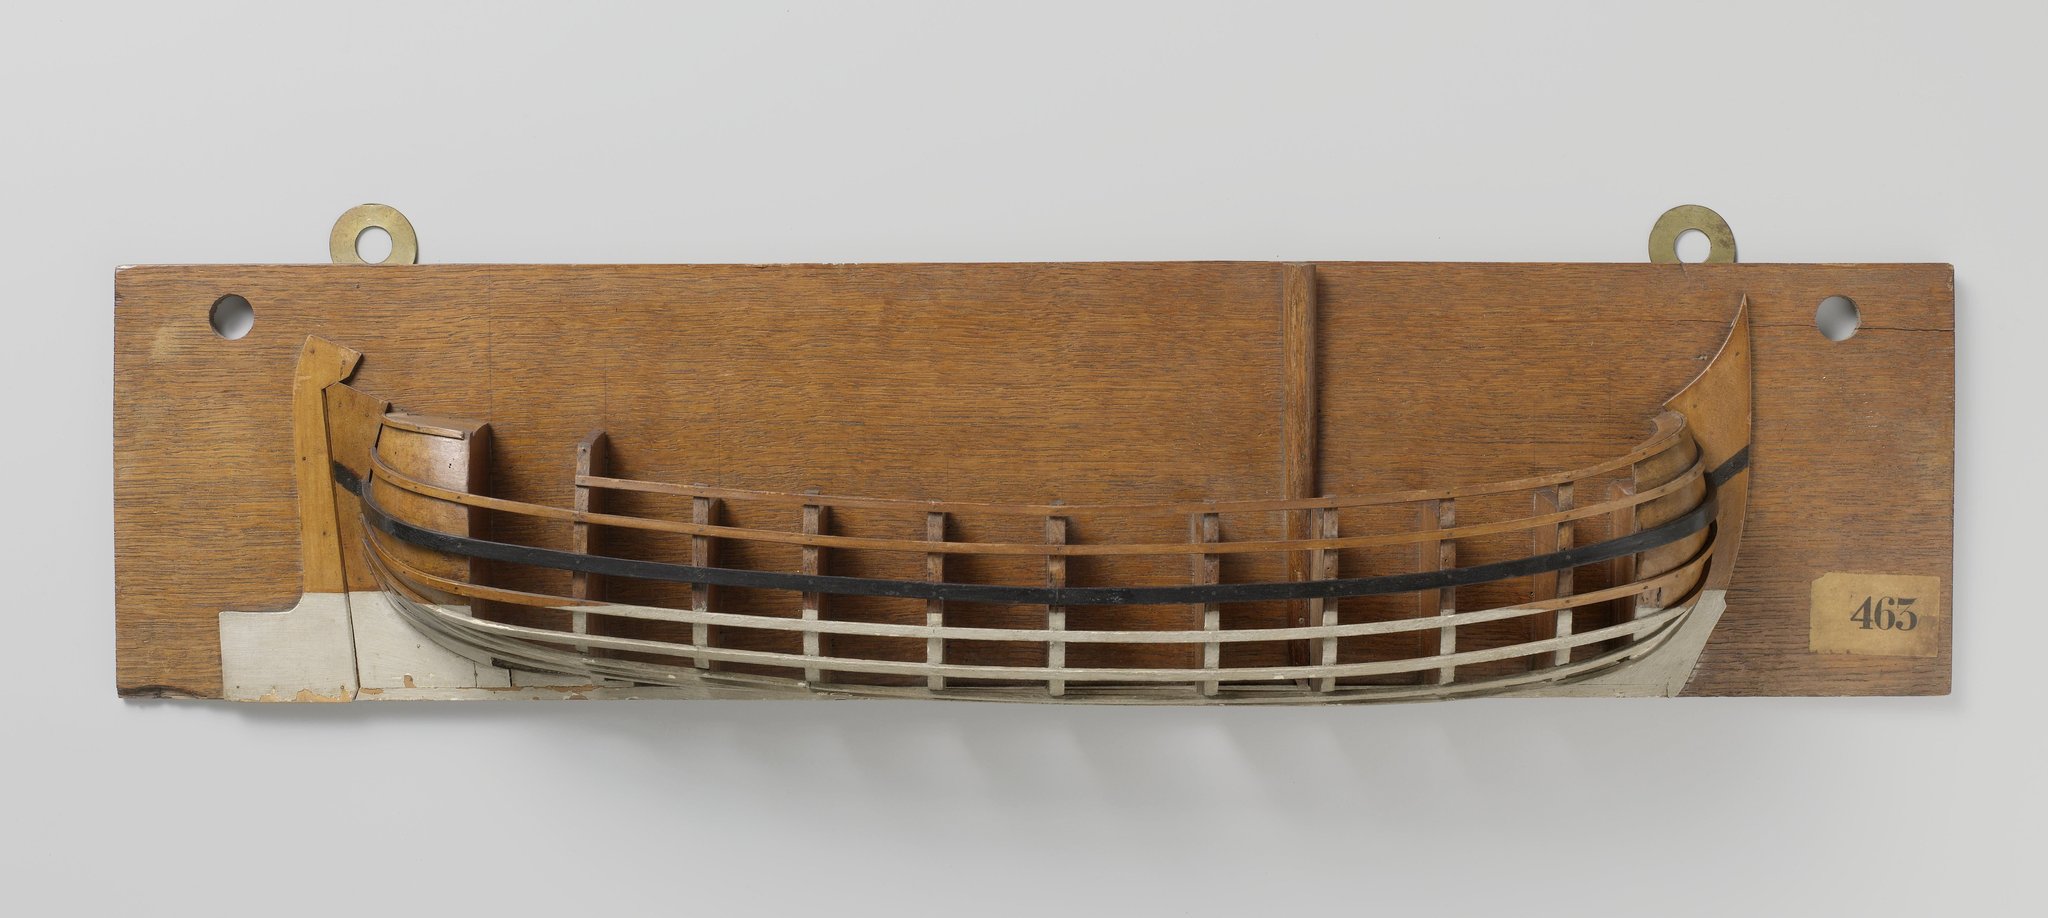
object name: ship model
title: Half Model of a Poon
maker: Anonymous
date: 1780-1820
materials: wood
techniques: polychromy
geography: netherlands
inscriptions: label, bottom right: ‘463’ former inventory label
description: Gepolychromeerd mallenmodel (stuurboord) van een platbodem eenmaster. Rond achterschip, breed roer, kiel met hieling. De zeeg loopt naar beide uiteinden op, barkhout doorlopend op voor- en achtersteven.